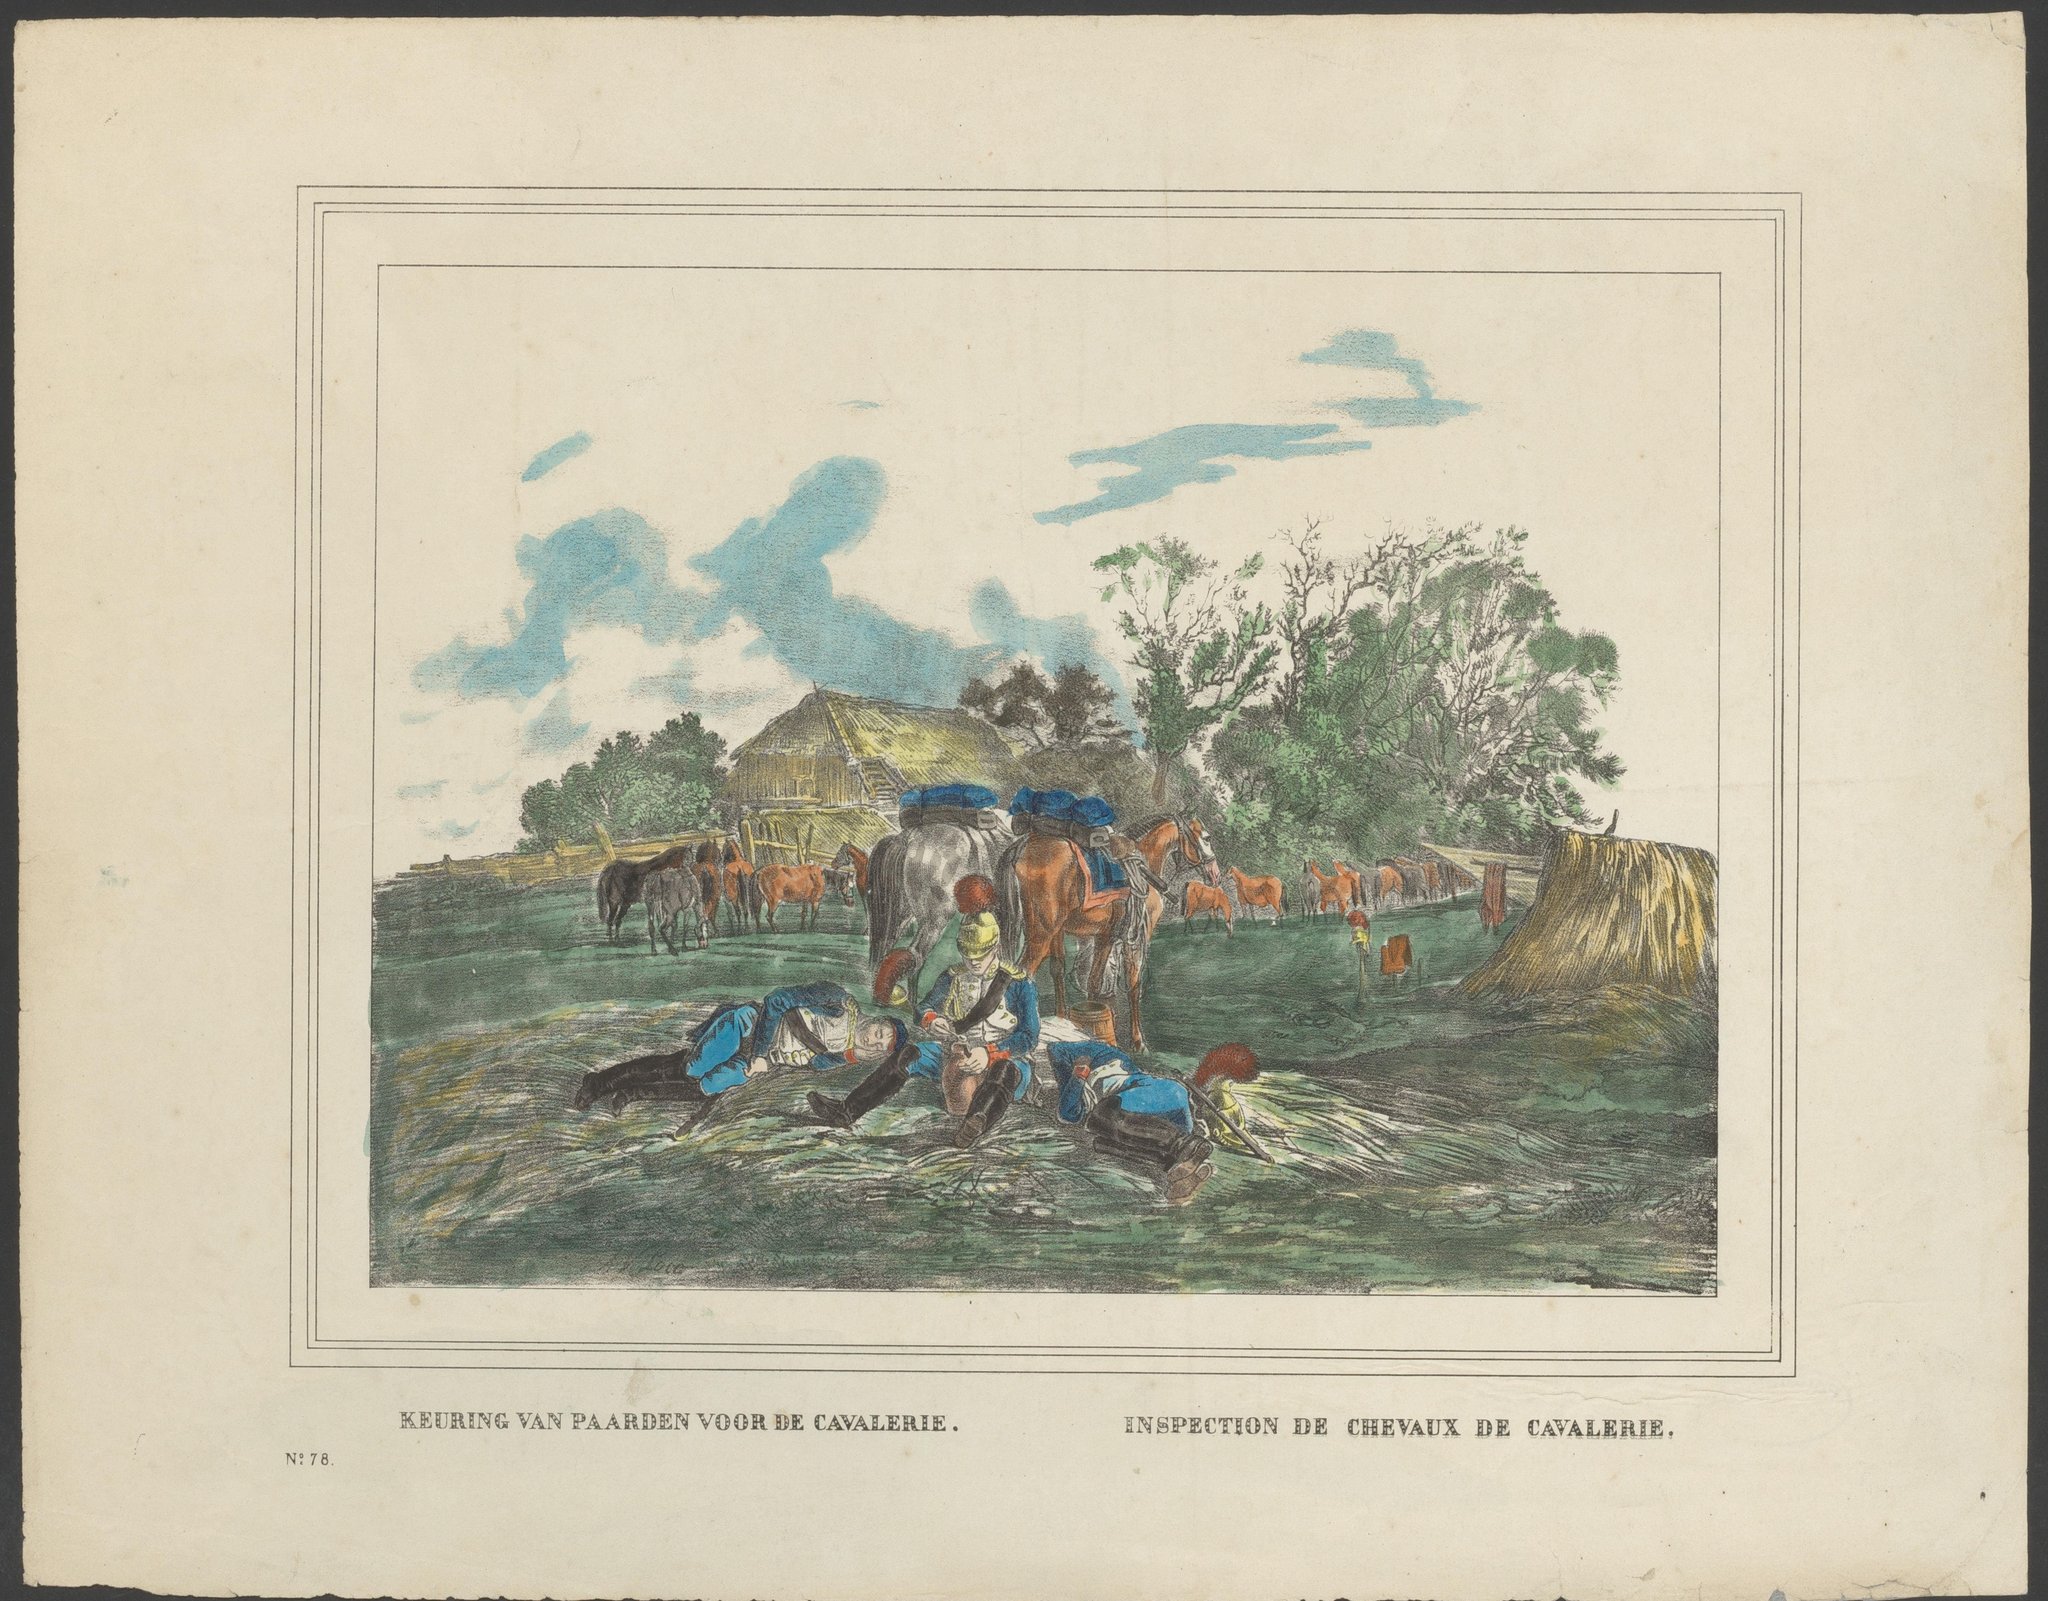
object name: print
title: Keuren van de paarden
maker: Anonymous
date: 1800-1899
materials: paper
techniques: hand coloring, lithograph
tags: the soldier; the soldier's life, the soldier off duty, grooming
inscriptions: collector's mark: Lugt 1641, stamp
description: Linksonder genummerd: No. 78. Onderwerpsrubrieken binnen de Atlas Zeden en Gewoonten: Zeden en Gewoonten in Engeren Zin, Des menschen beging, midden en einde, Kinderleven – Kinderspel en Kinderprenten.